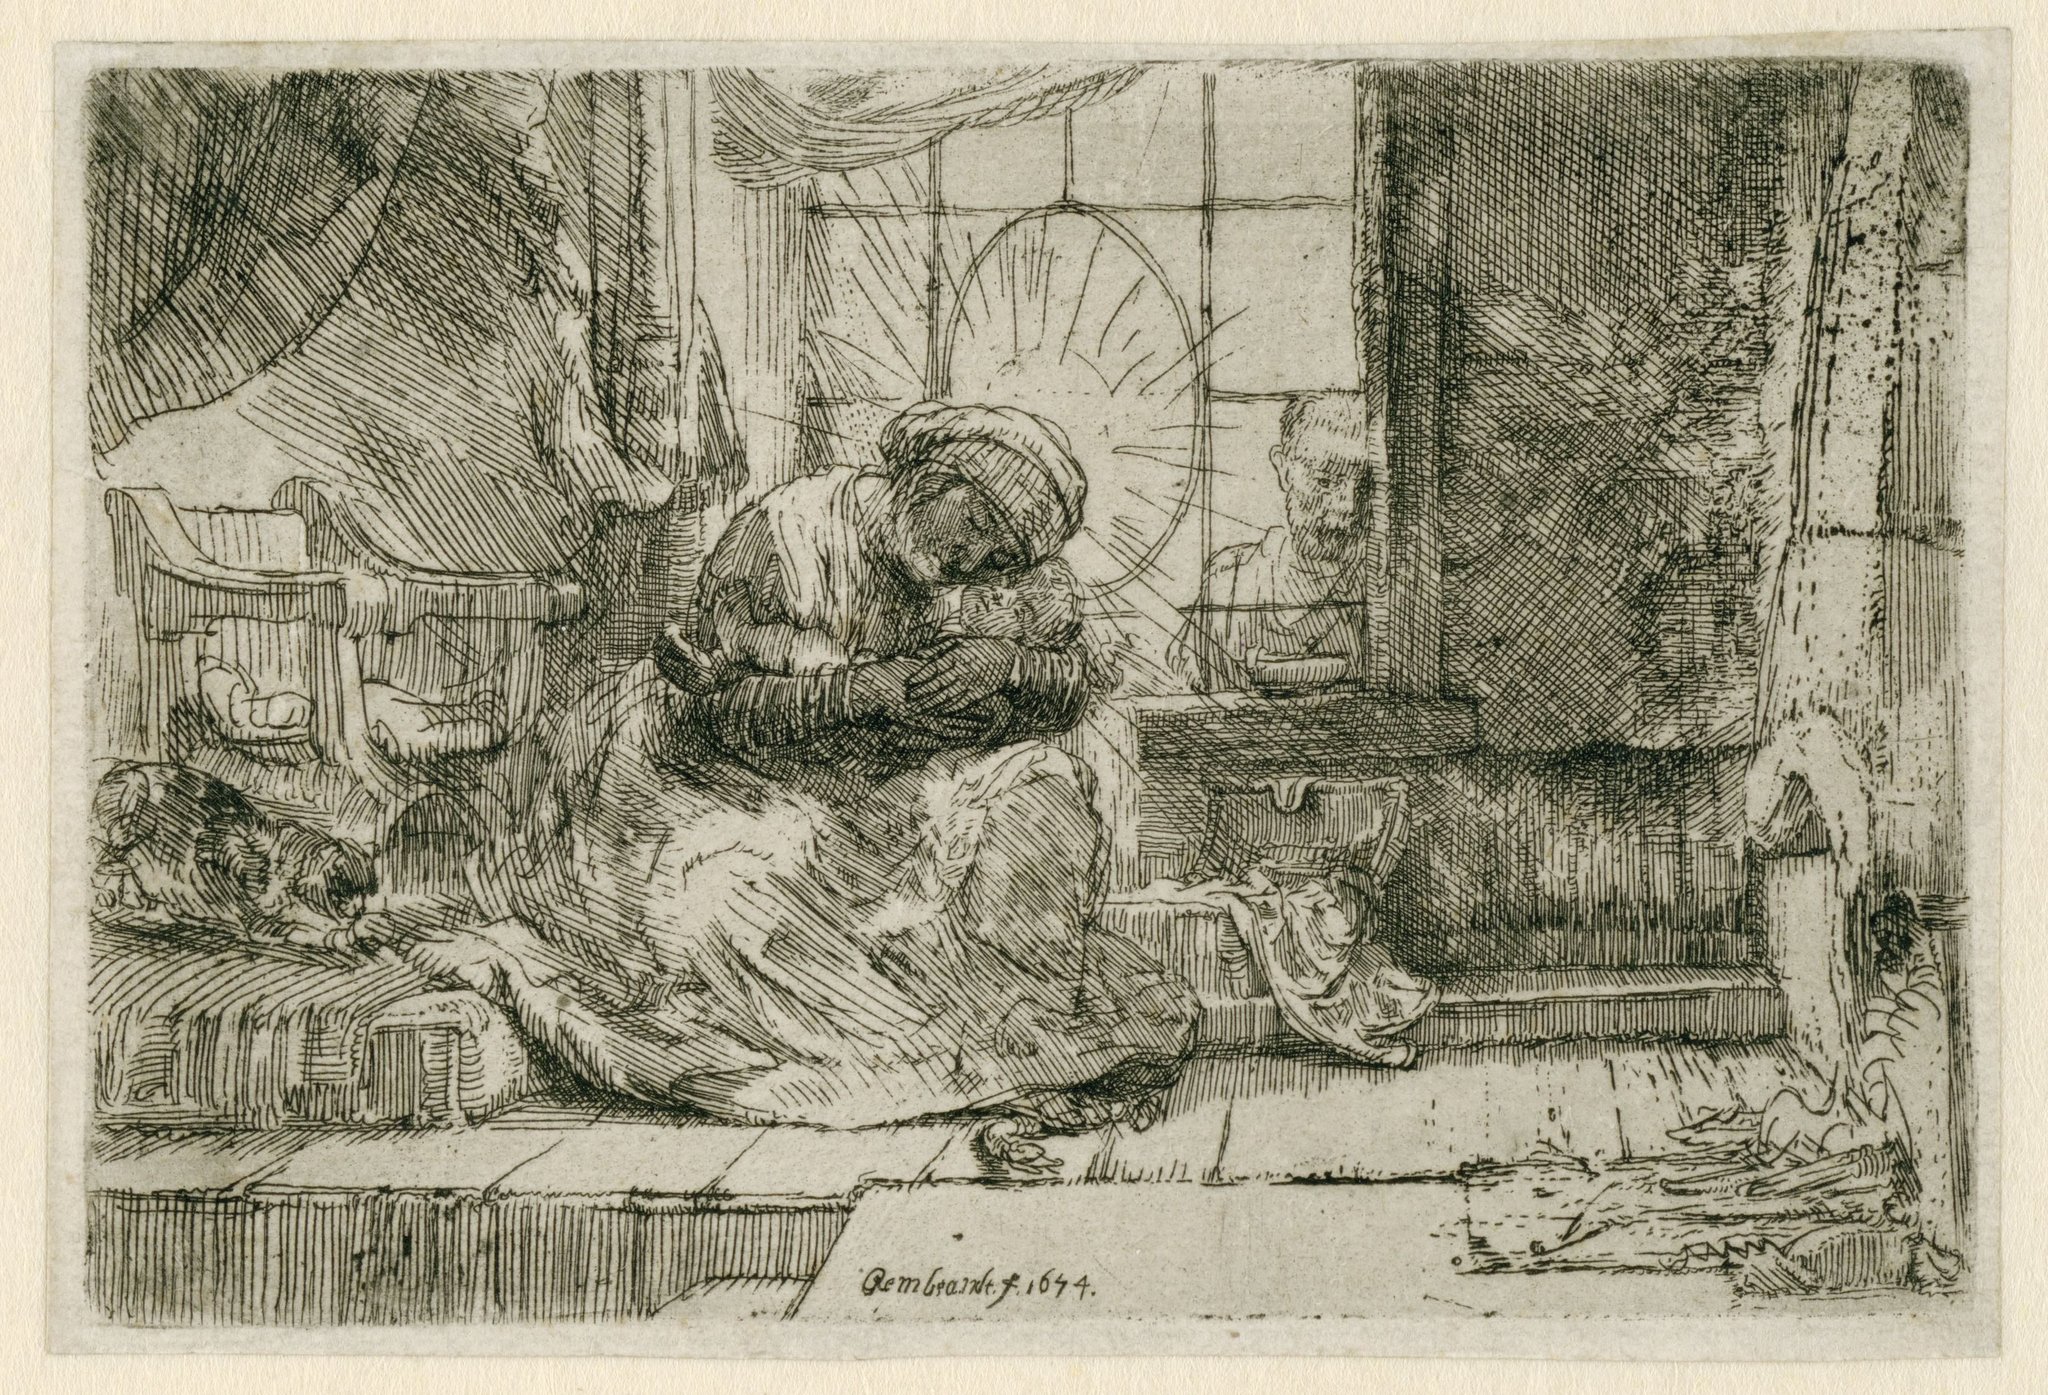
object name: print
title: The Virgin and Child with the cat and the snake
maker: rembrandt van rijn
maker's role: draughtsman, painter, print maker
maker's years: 1606-1669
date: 1654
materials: paper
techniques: etching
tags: madonna: mary sitting on the ground, the christ-child in her lap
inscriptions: signature and date: ‘Rembrandt.f.1654’ Lugt, mark: Lugt 2228 a, mark: 2805